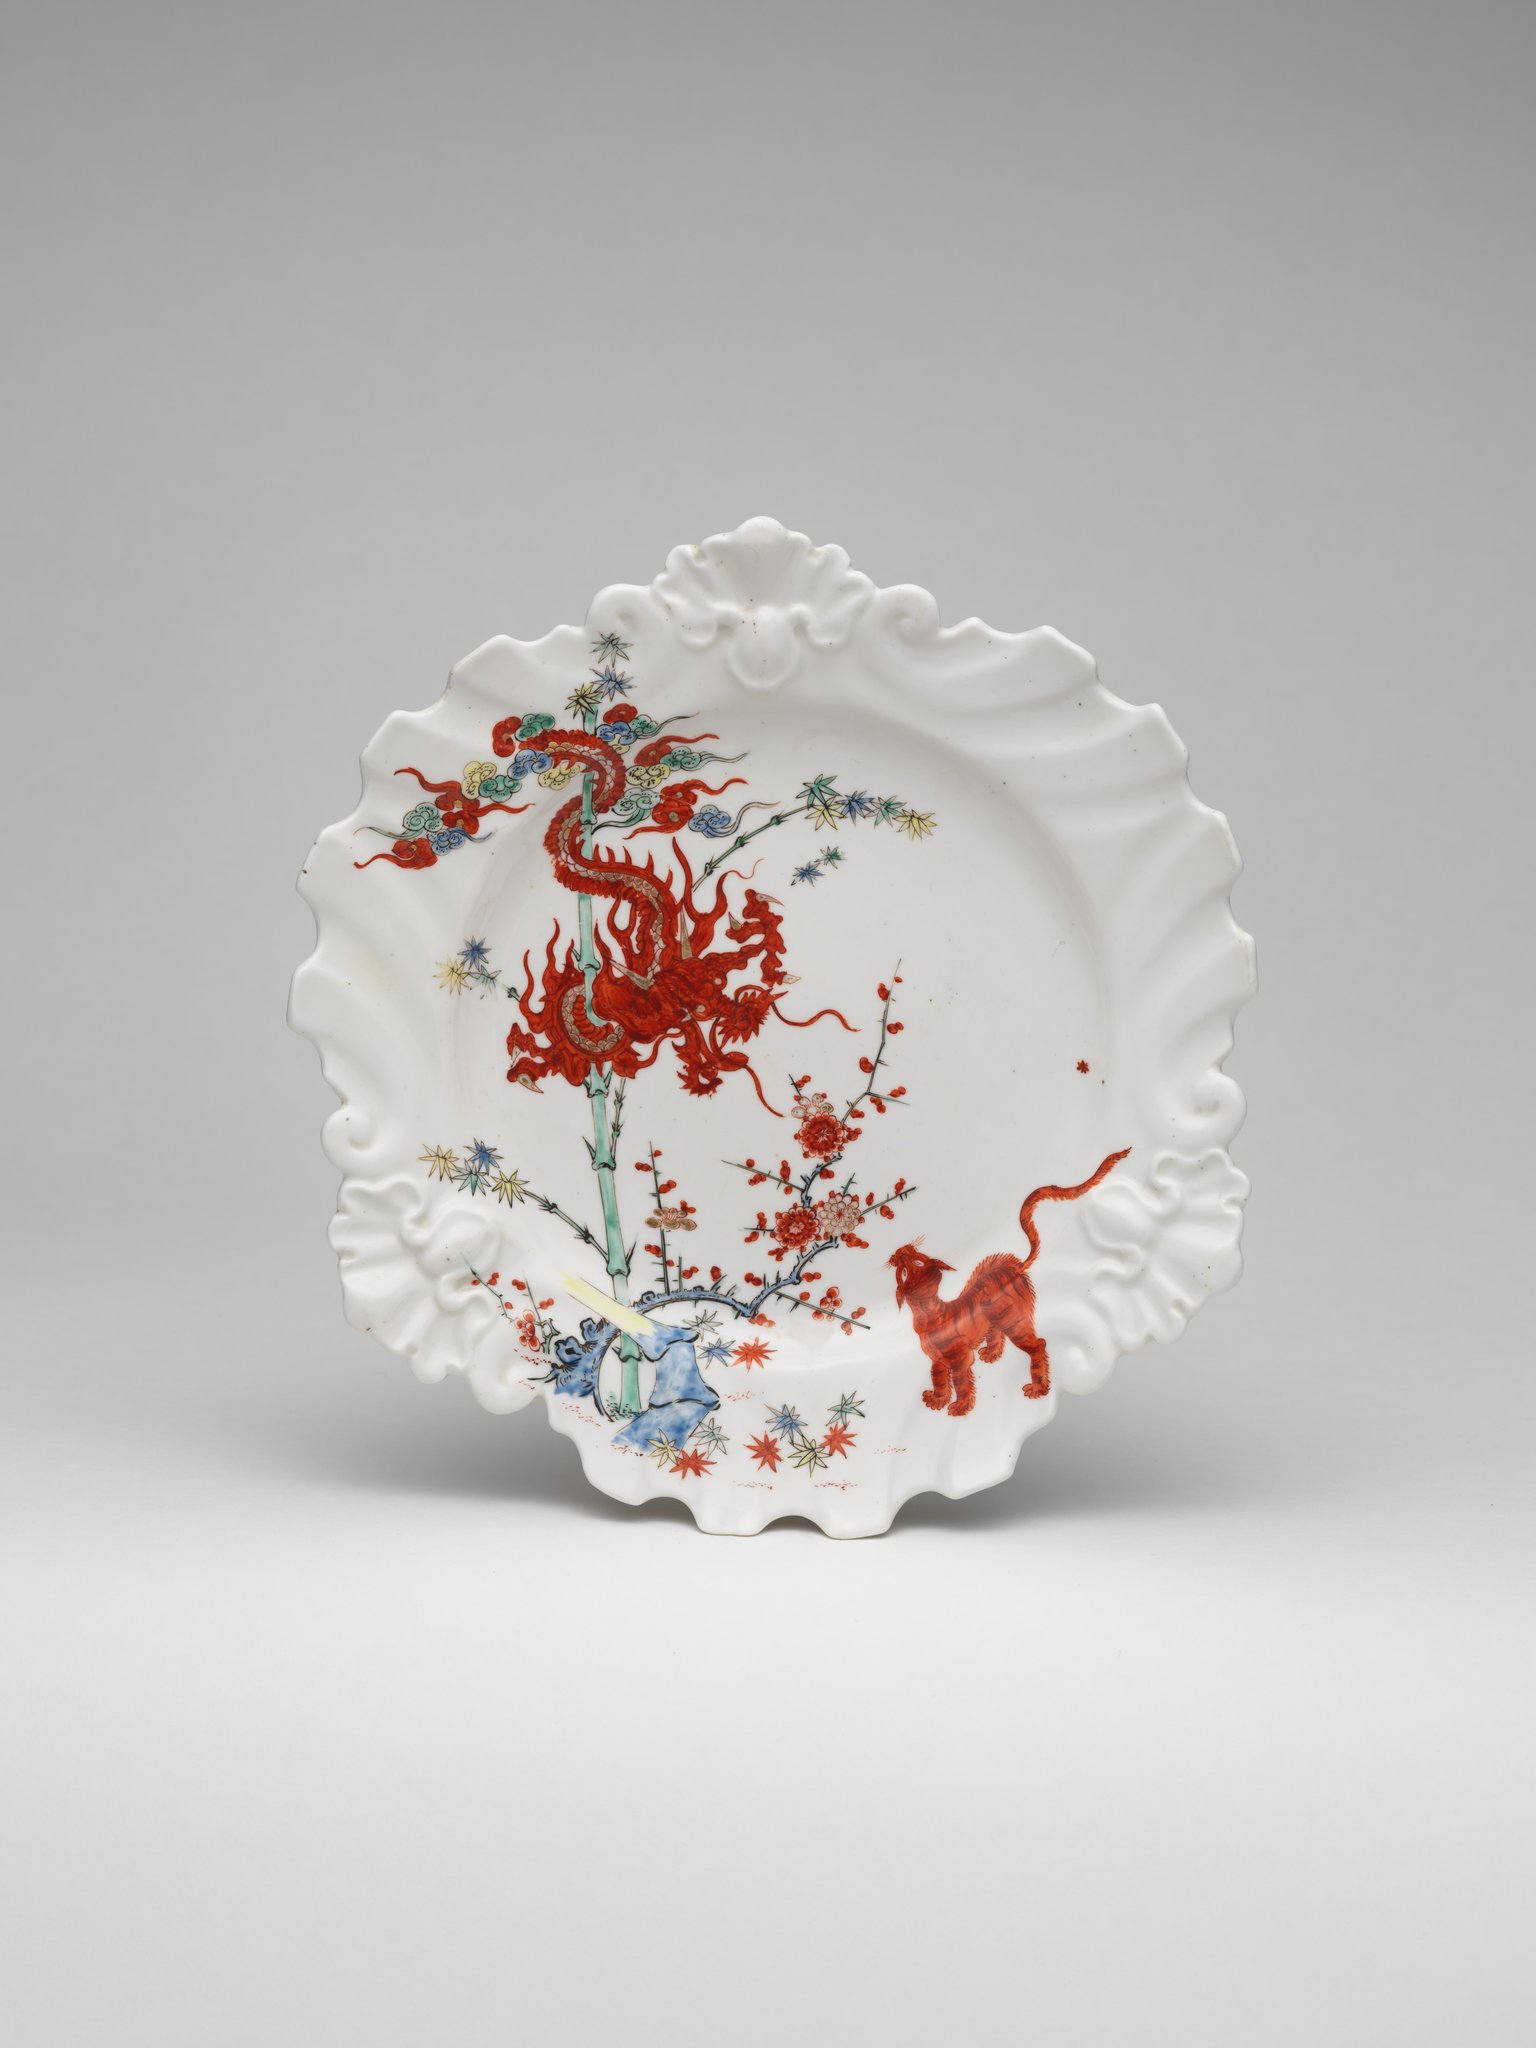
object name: plate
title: Plate decorated with Japanese Kakiemon-inspired scene with twisted dragon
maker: chelsea porcelain manufactory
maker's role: factory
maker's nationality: british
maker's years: 1744-1784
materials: soft paste porcelain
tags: dragons,tigers